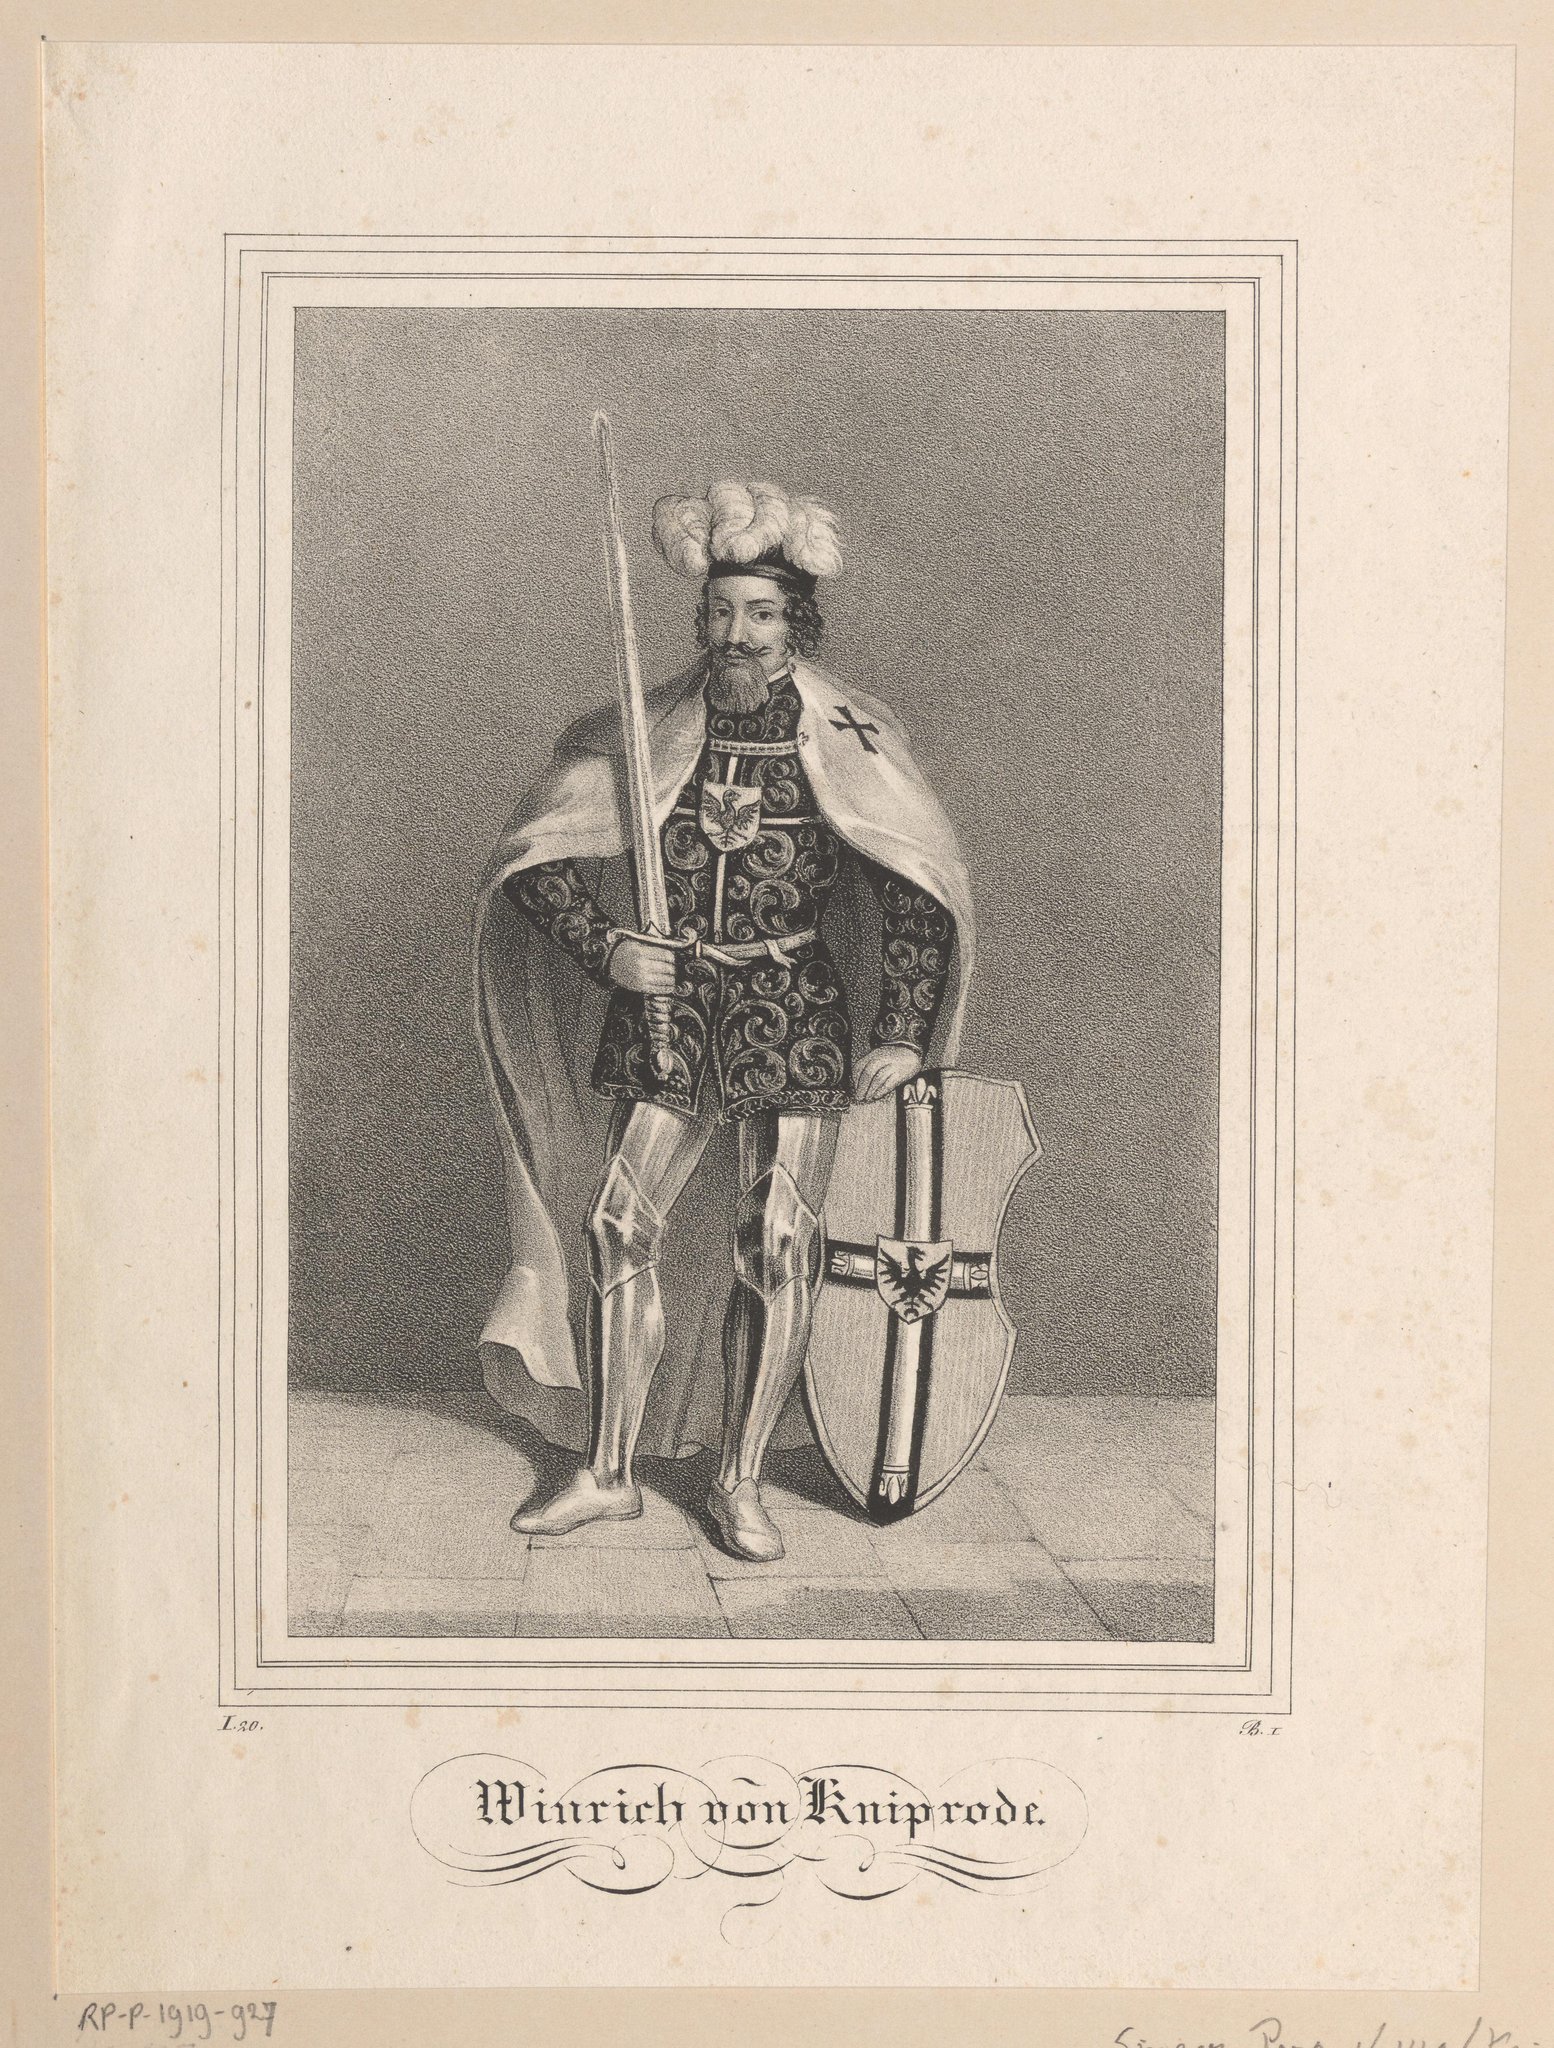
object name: print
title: Portret van Winrich von Kniprode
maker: Anonymous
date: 1838-1842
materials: paper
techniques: lithograph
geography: dresden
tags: historical persons, hacking and thrusting weapons: sword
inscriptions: collector's mark: Lugt 2228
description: Prent uit: Borussia, museum für preussische Vaterlandskunde (...). Dresden: s.n., 1838-1842.